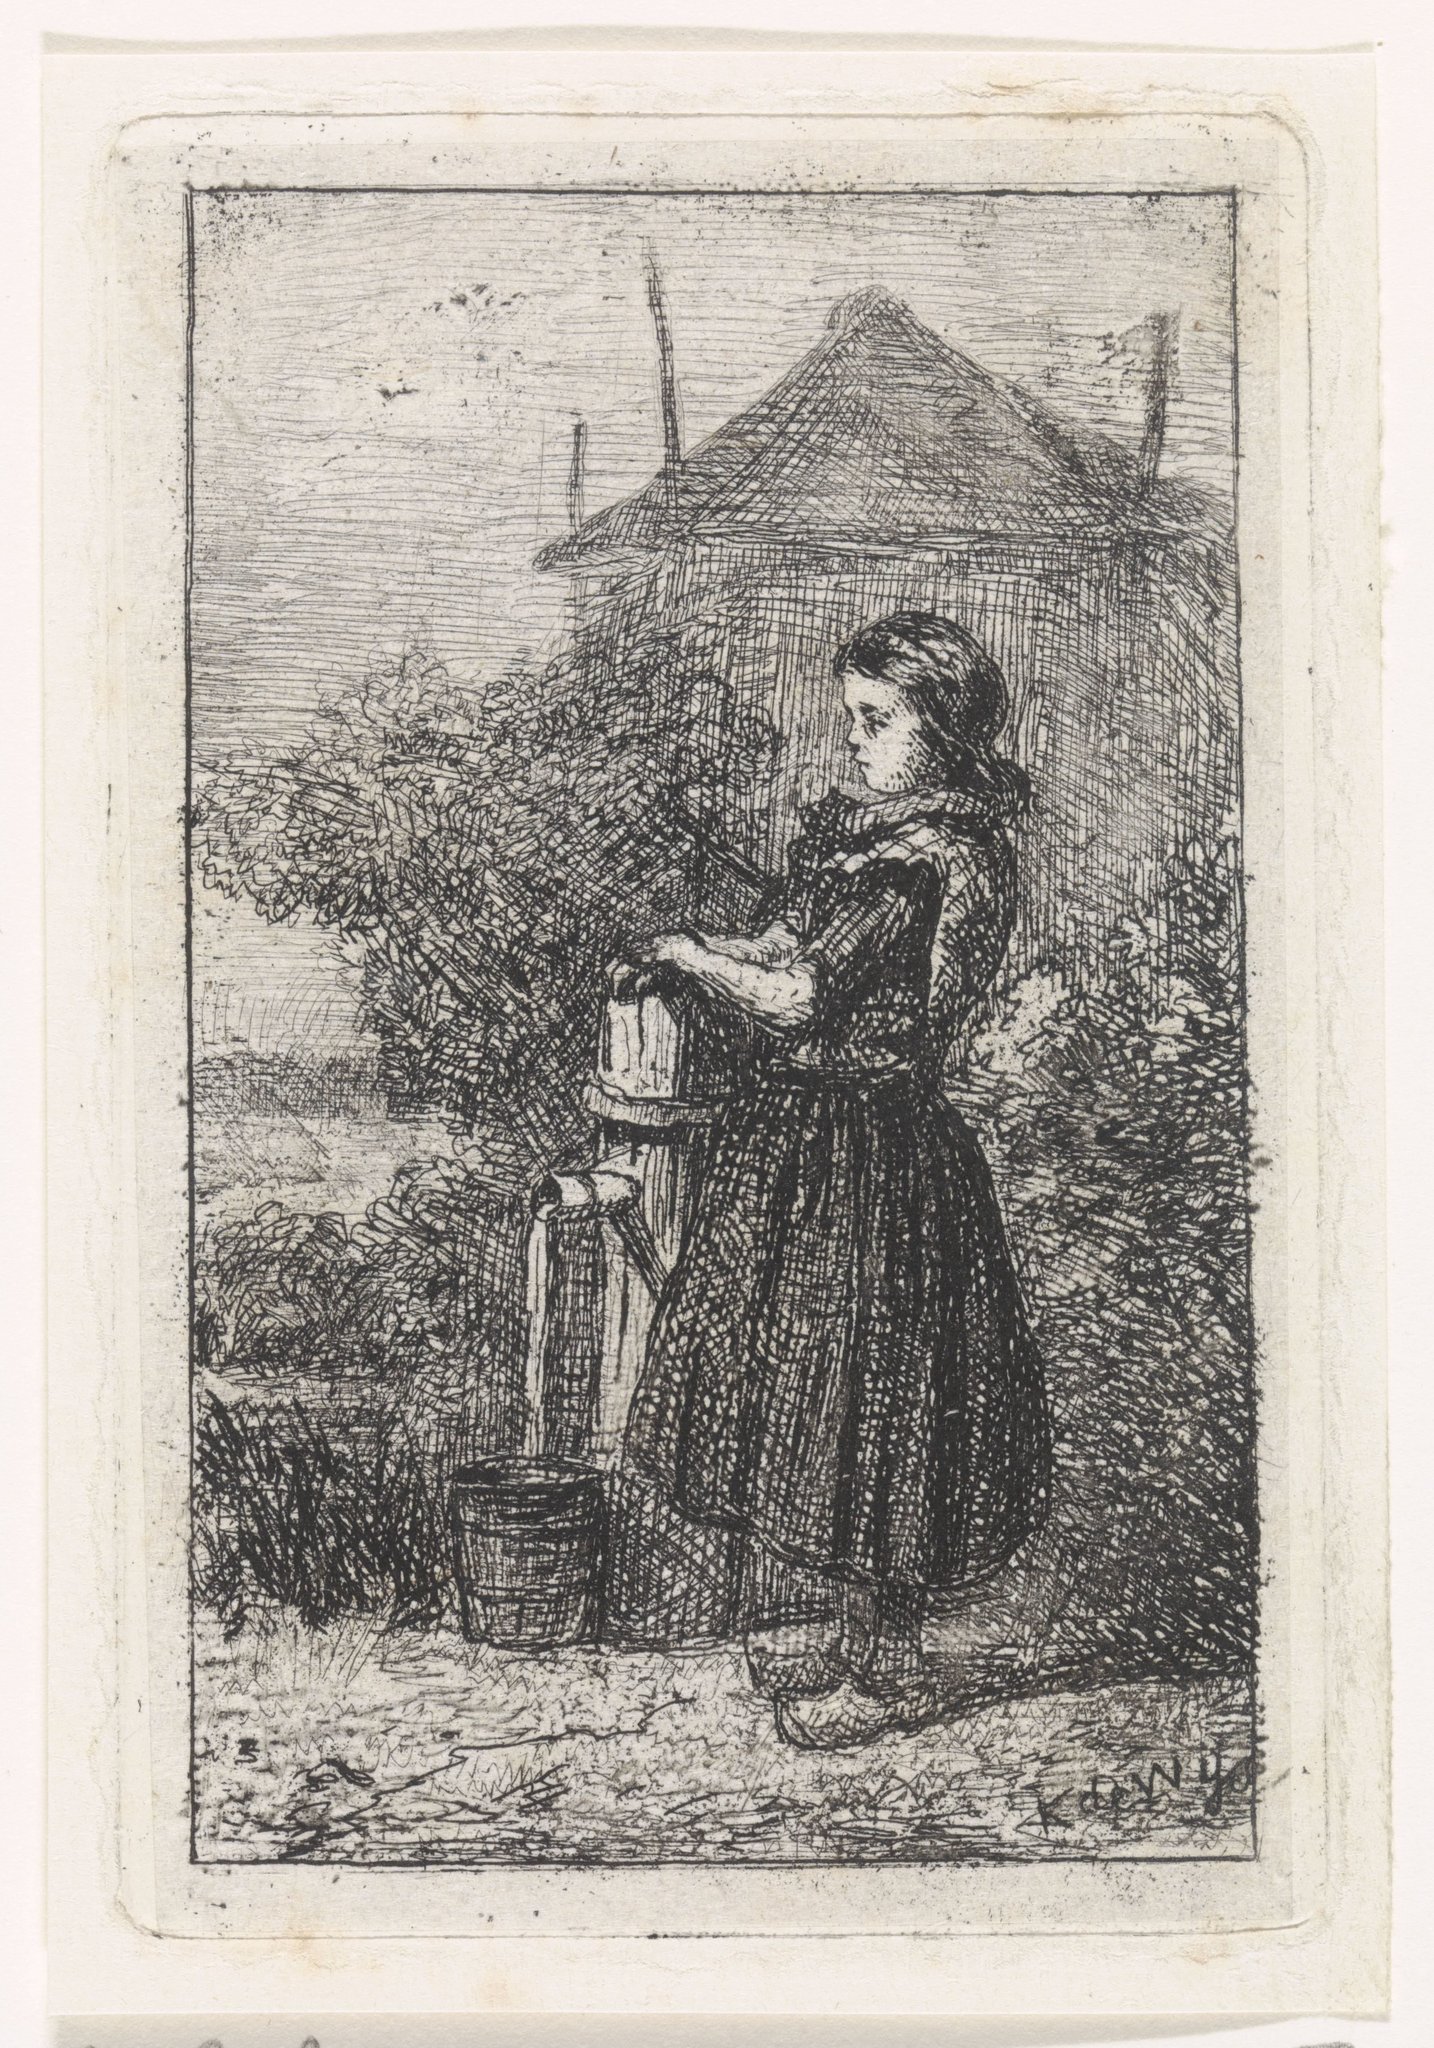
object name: print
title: Meisje bij een waterpomp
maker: kornelis jzn de wijs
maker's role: print maker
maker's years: 1832-1896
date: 1842-1896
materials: paper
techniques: etching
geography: netherlands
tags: girl (child between toddler and youth), utilitarian, public pump or water fountain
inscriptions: collector's mark: Lugt 2228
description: Een meisje bij een waterpomp. Op de achtergrond een hooiberg.